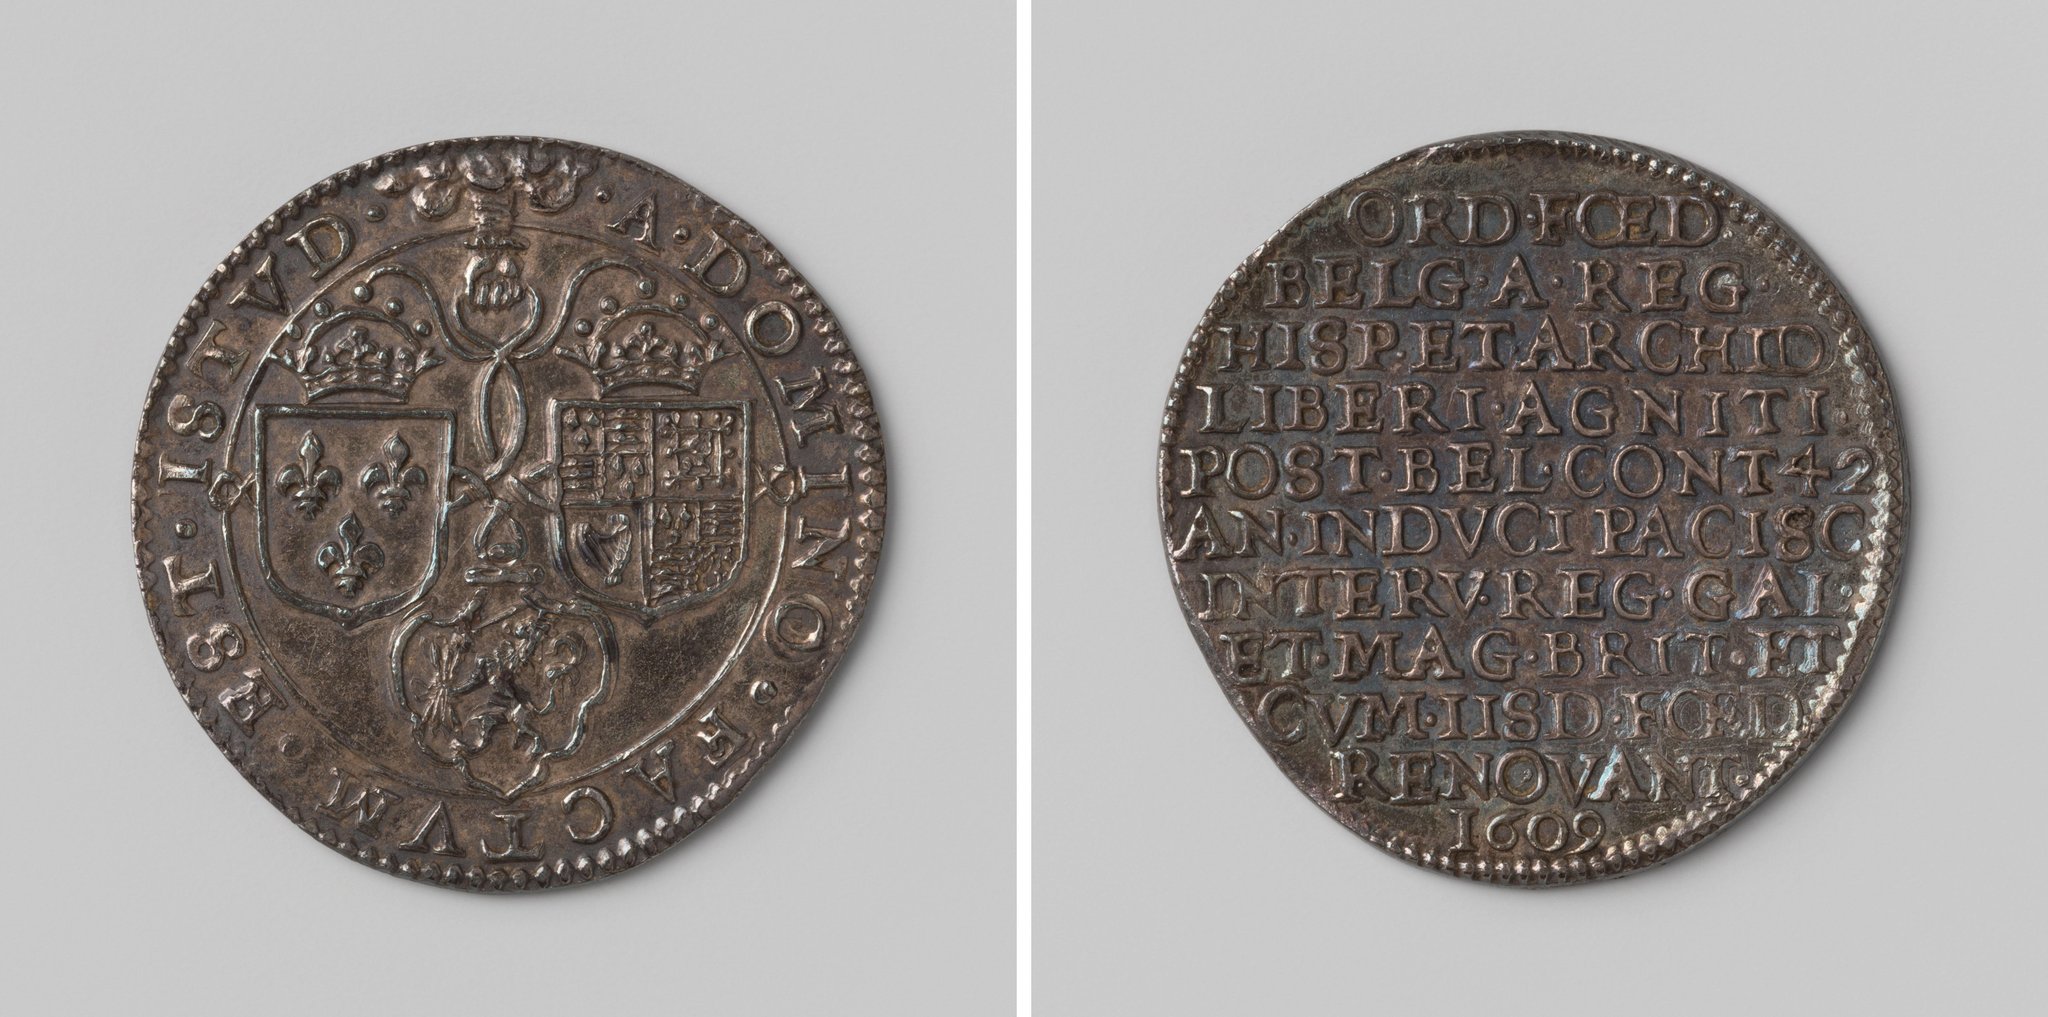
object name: jeton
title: Sluiting van het Twaalfjarig Bestand tussen de Republiek en Spanje, en hernieuwing van het drievoudige verbond tussen Engeland, Frankrijk en de Republiek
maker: Anonymous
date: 1609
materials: silver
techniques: striking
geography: netherlands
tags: netherlands, france, england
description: Zilveren penning. Voorzijde: hand uit wolken houdt lint vast, waaraan een ongekroond en twee gekroonde wapenschilden hangen binnen omschrift. Keerzijde: opschrift.